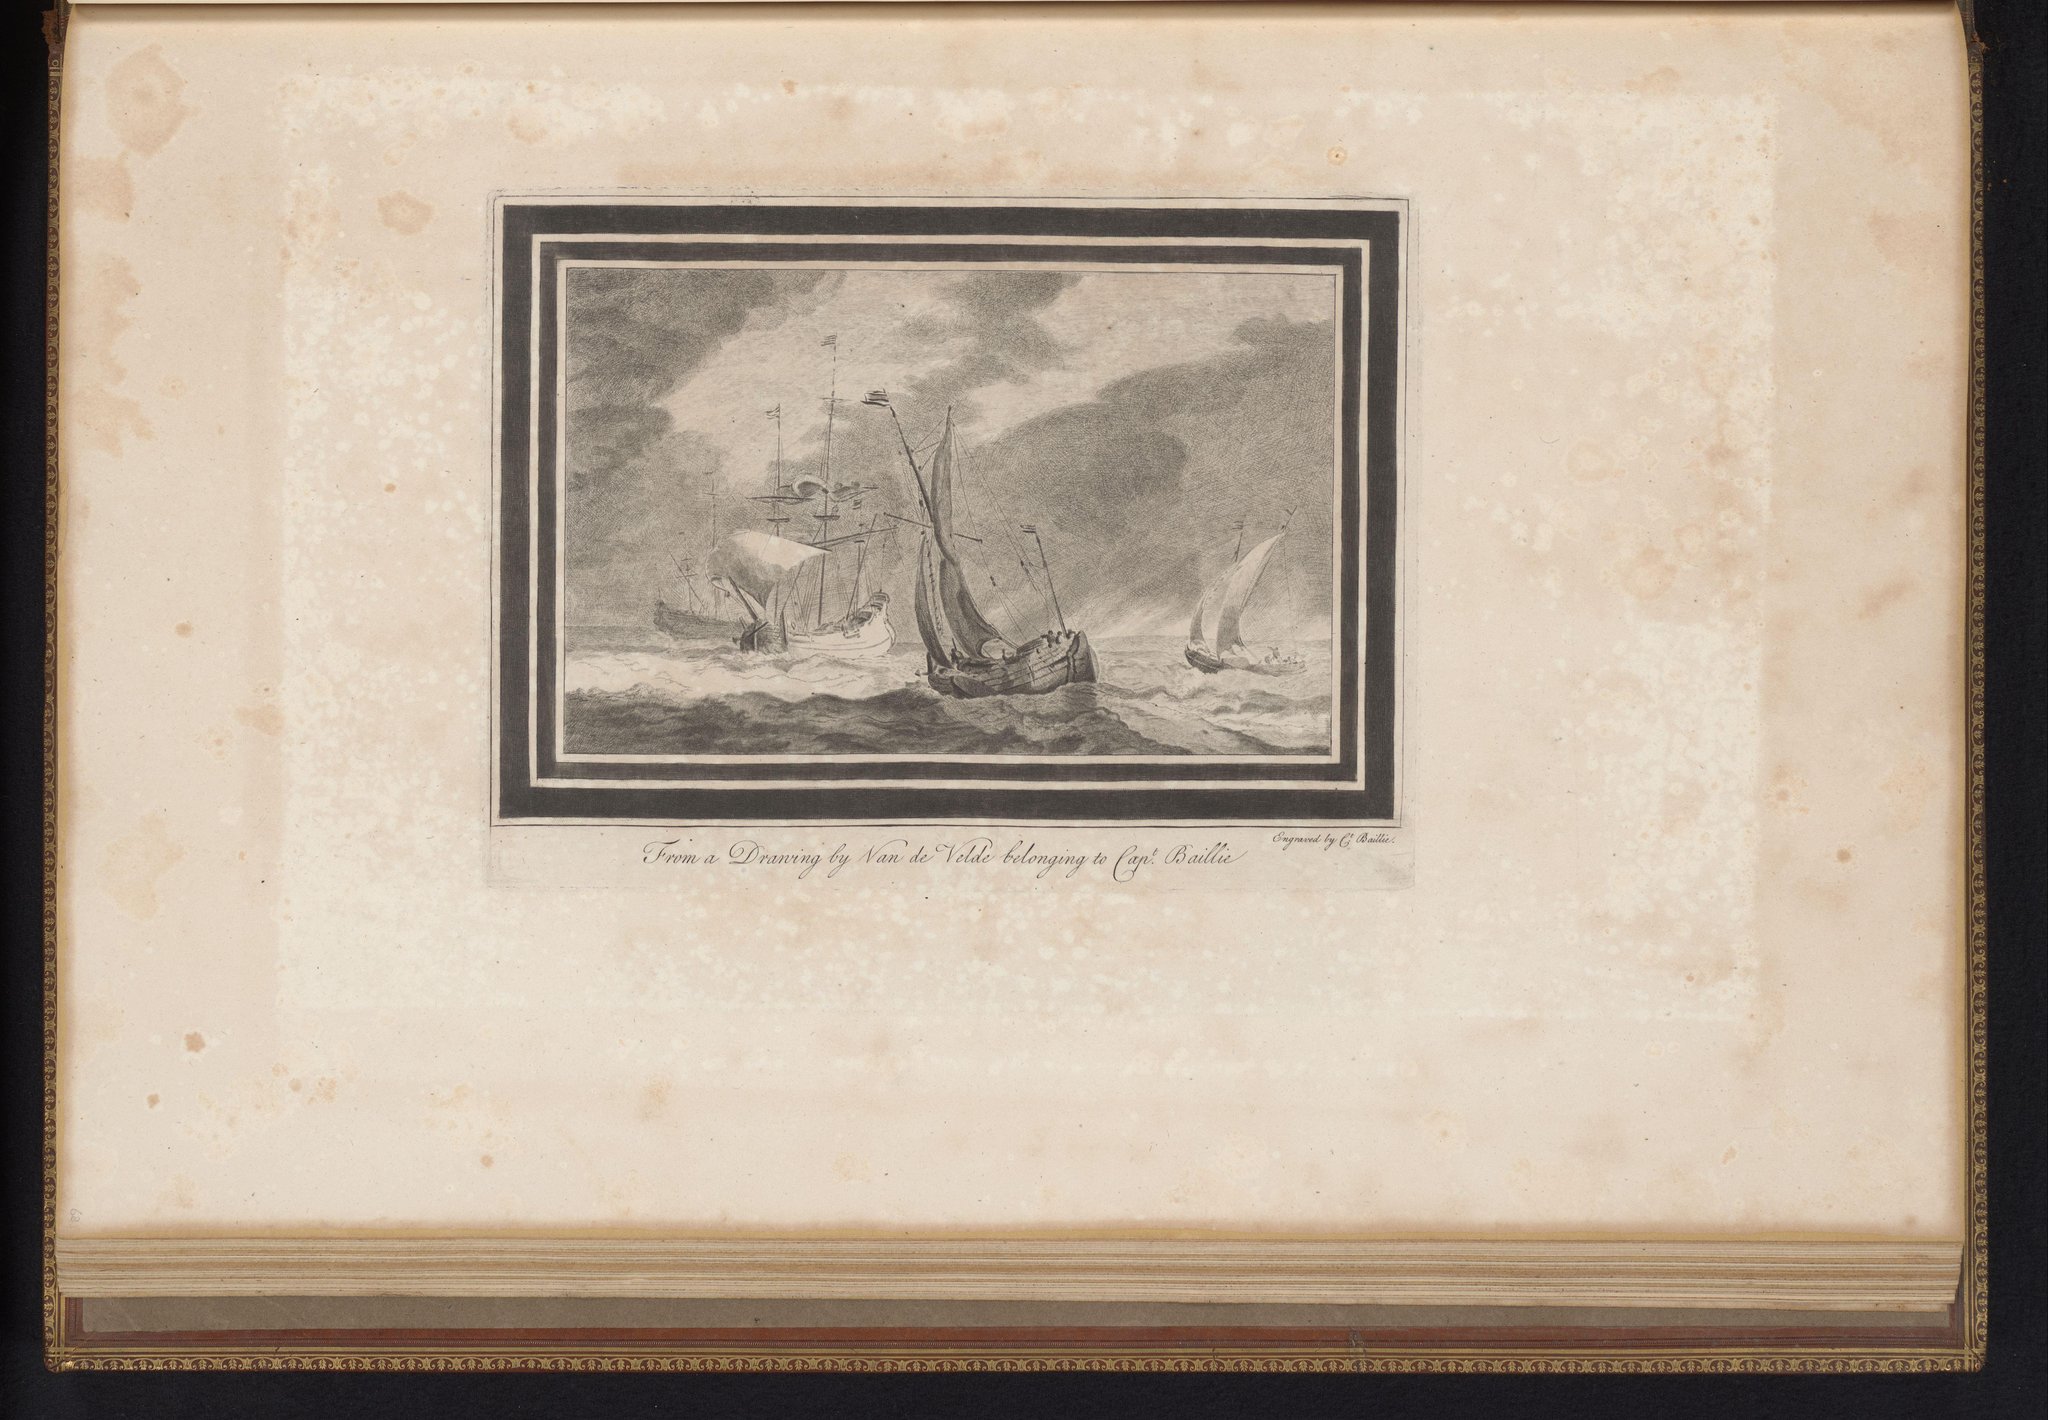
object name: print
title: Vier zeilschepen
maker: william baillie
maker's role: print maker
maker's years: 1723-1810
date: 1753-1810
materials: paper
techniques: etching, roulette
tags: sea (seascape), laundering